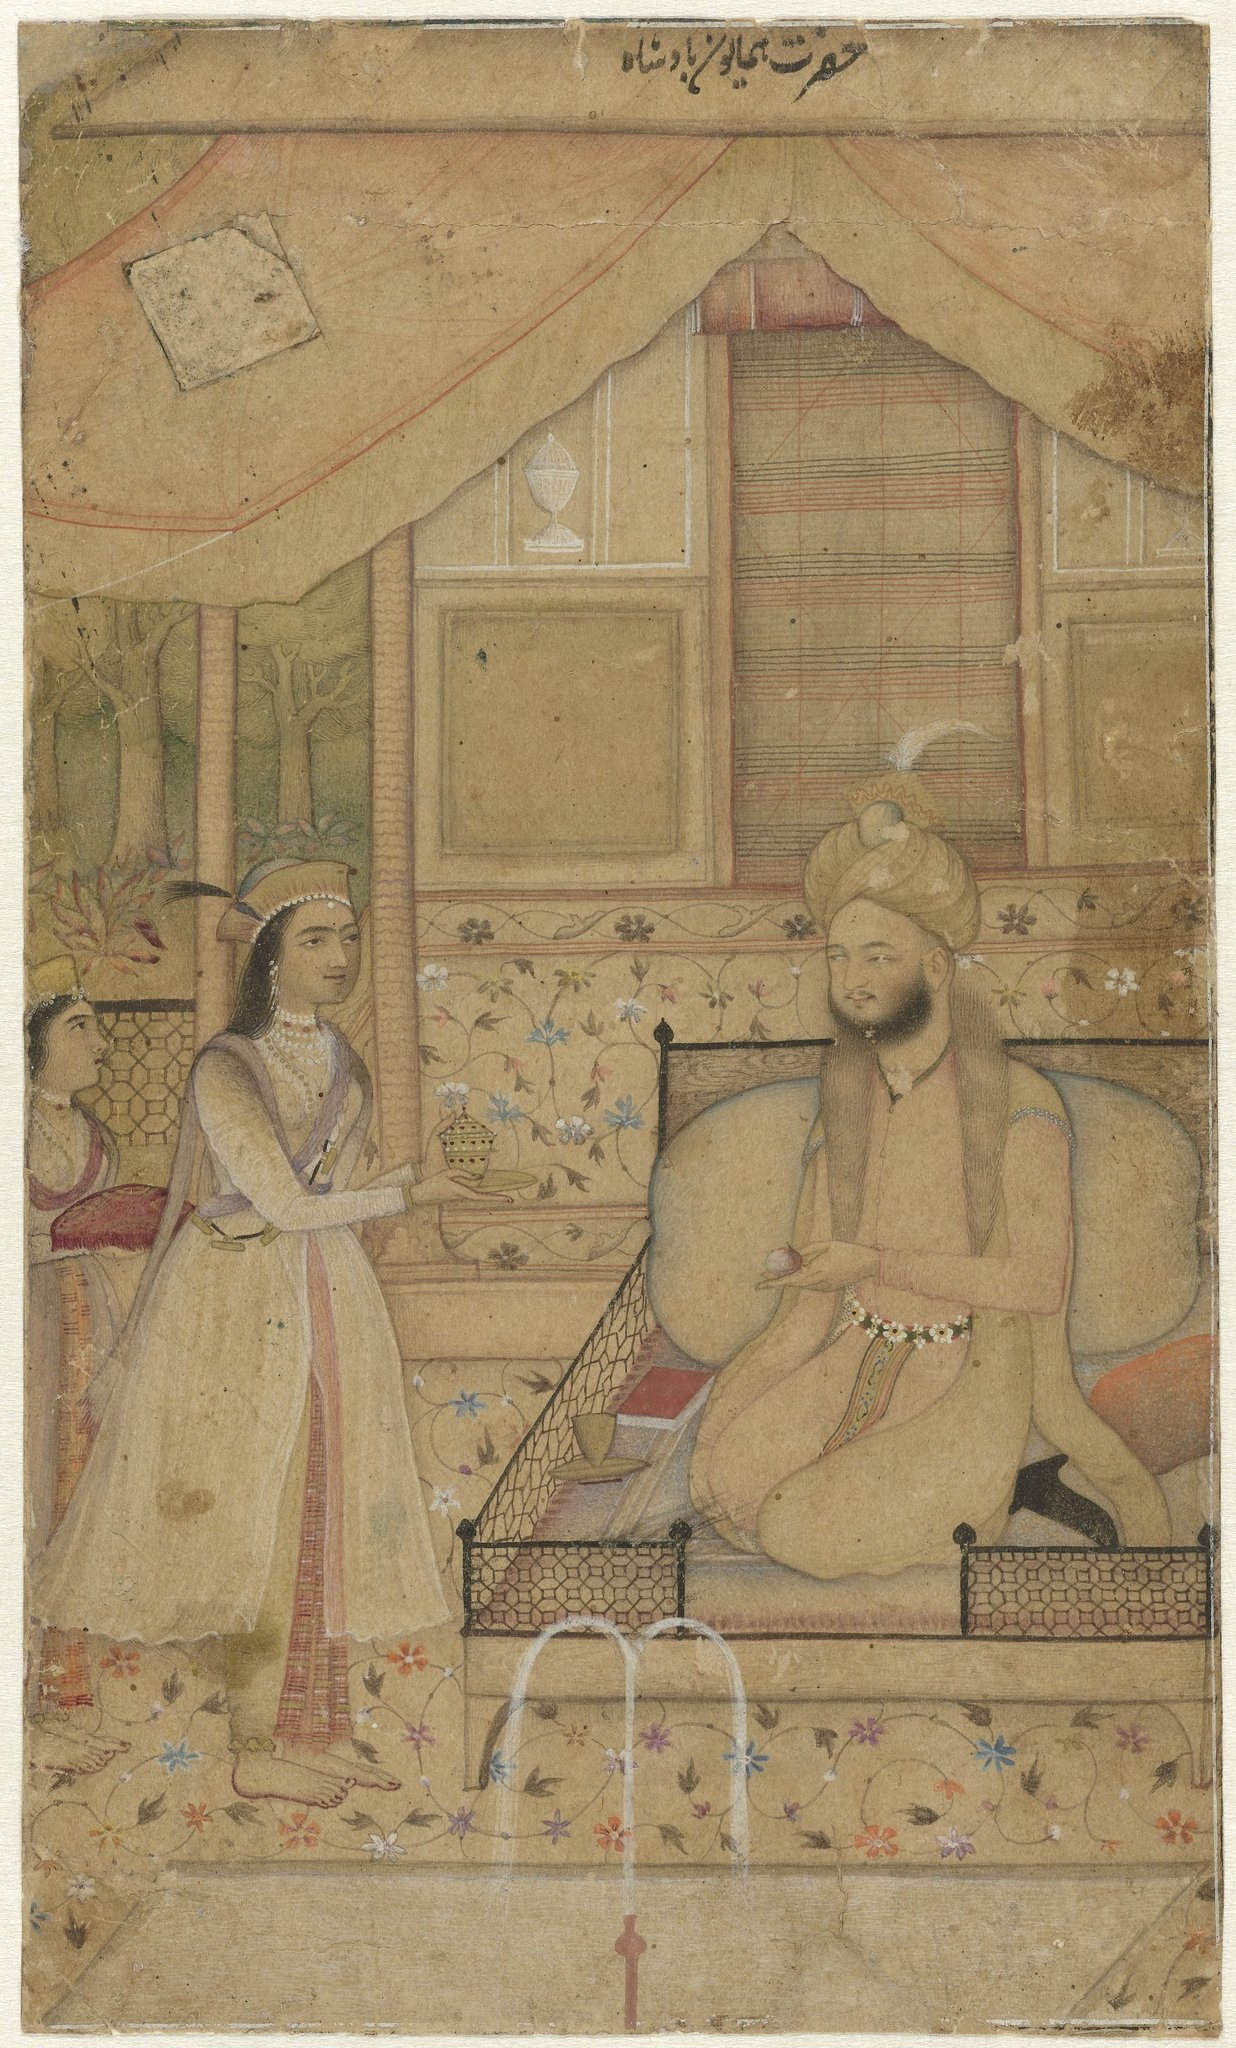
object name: indian miniature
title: Vorst met twee dienaressen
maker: Anonymous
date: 1670-1690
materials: paper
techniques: brush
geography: kashmir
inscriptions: inscription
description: Een vorst zittend op een bed laat zich bedienen door een vrouw die links staat, achter haar een tweede vrouwenfiguur met een kussentje in haar handen.